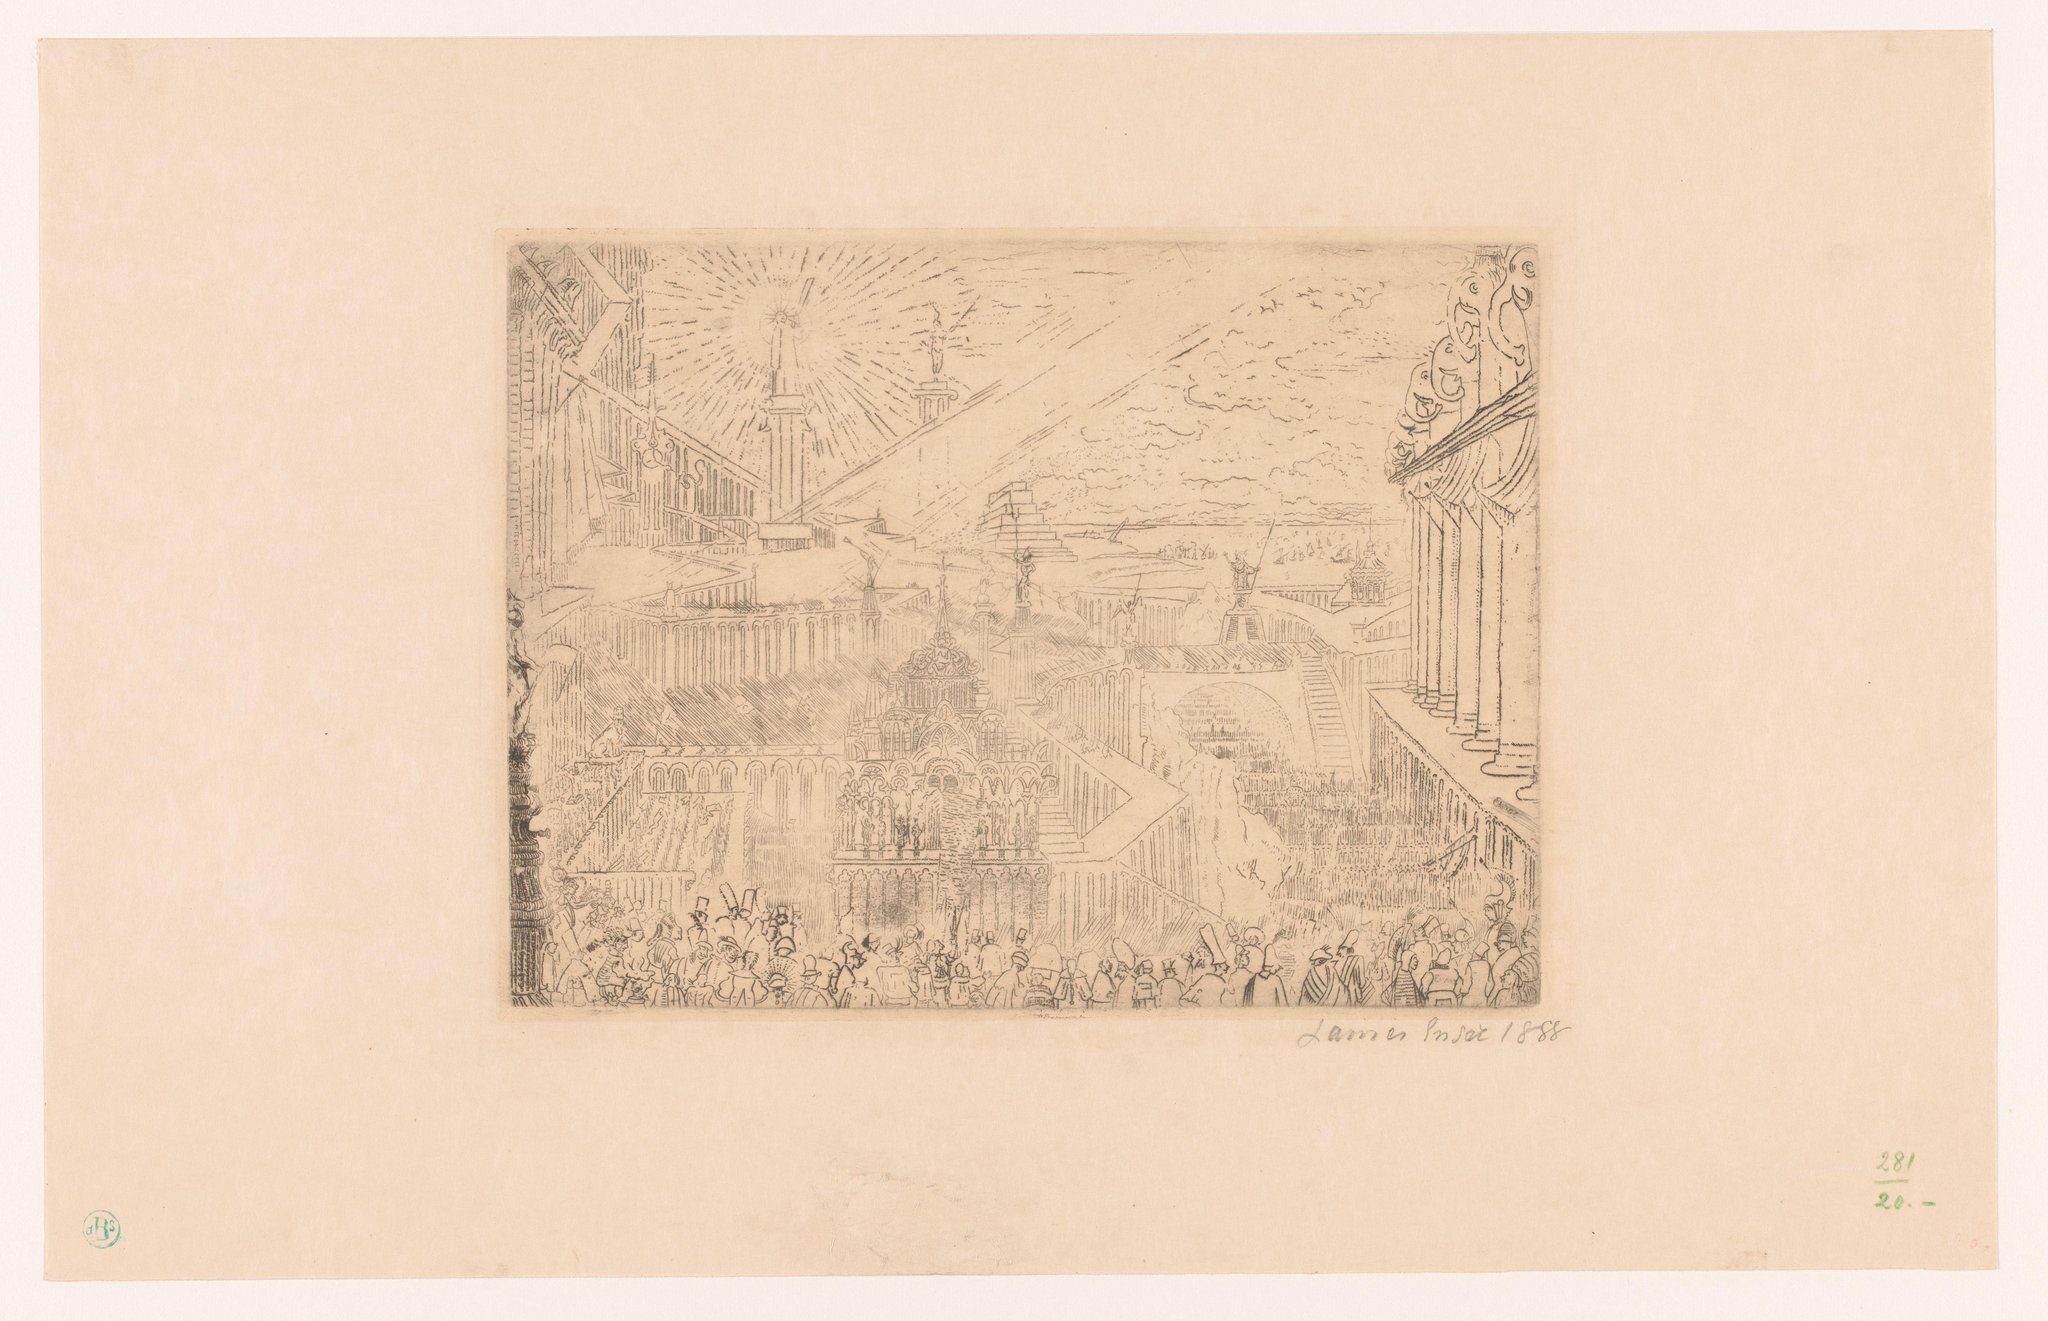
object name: print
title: Gezicht op een fantasiestad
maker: james ensor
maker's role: print maker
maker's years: 1860-1949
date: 1888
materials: paper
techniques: etching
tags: city-view in general; 'veduta' - ii - ideal city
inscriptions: collector's mark: Lugt 2233, collector's mark: Lugt 733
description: De stad bestaat uit vele galerijen en verspreid staan diverse standbeelden op sokkels.